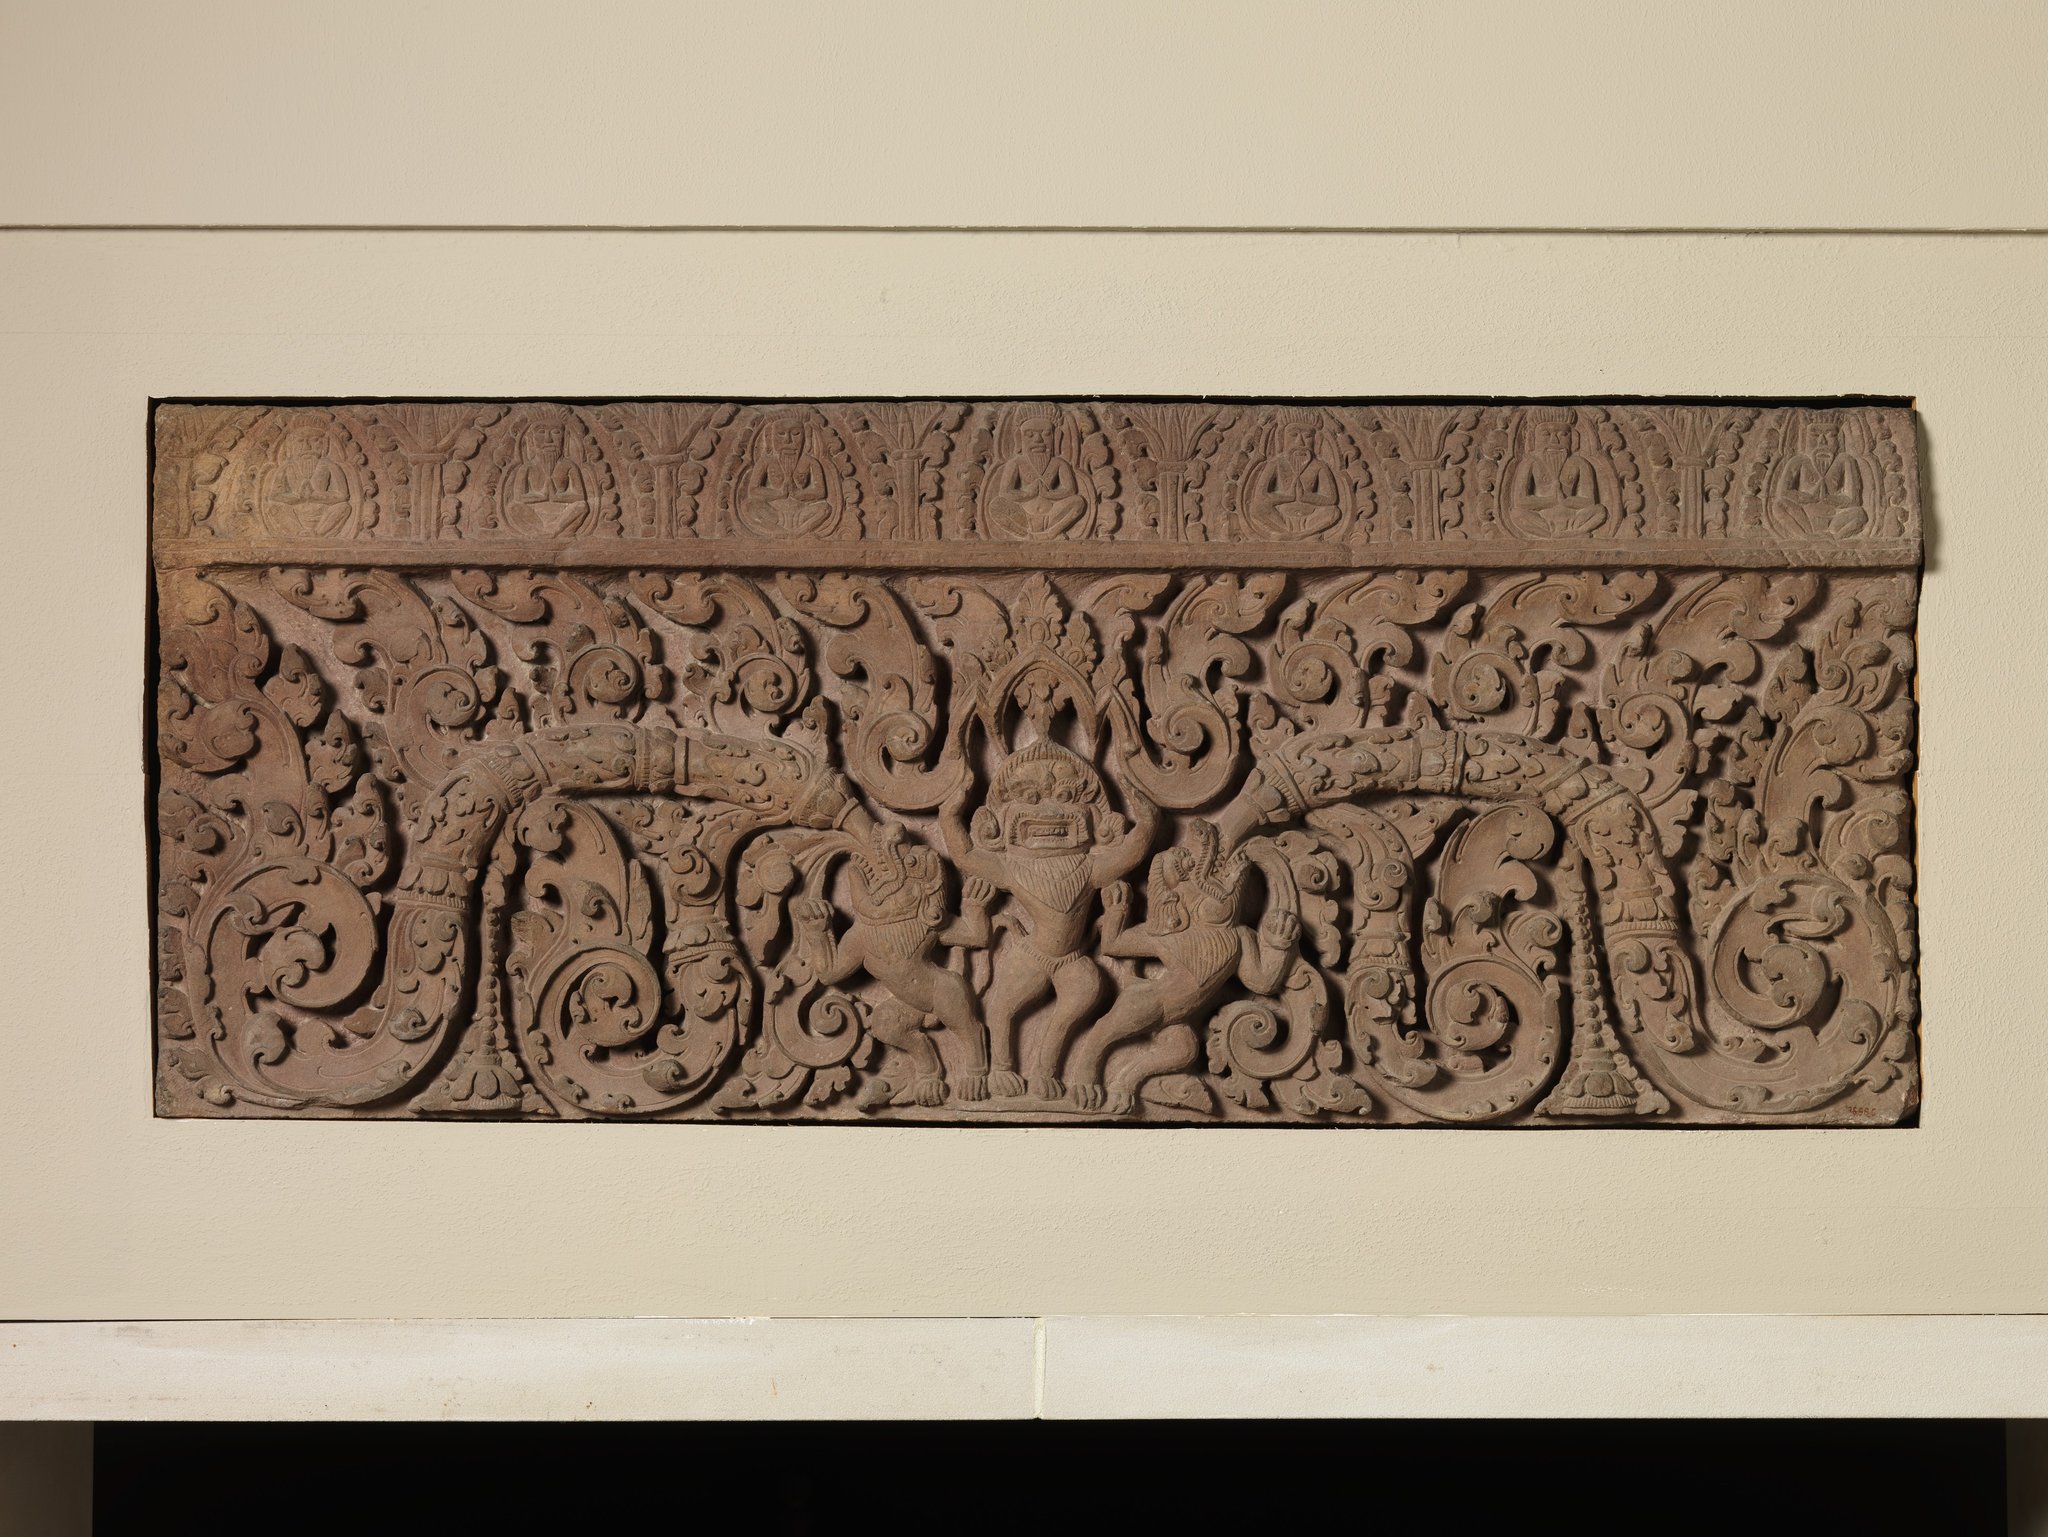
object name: figure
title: Lintel with Carved Figures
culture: cambodian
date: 921-945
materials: stone